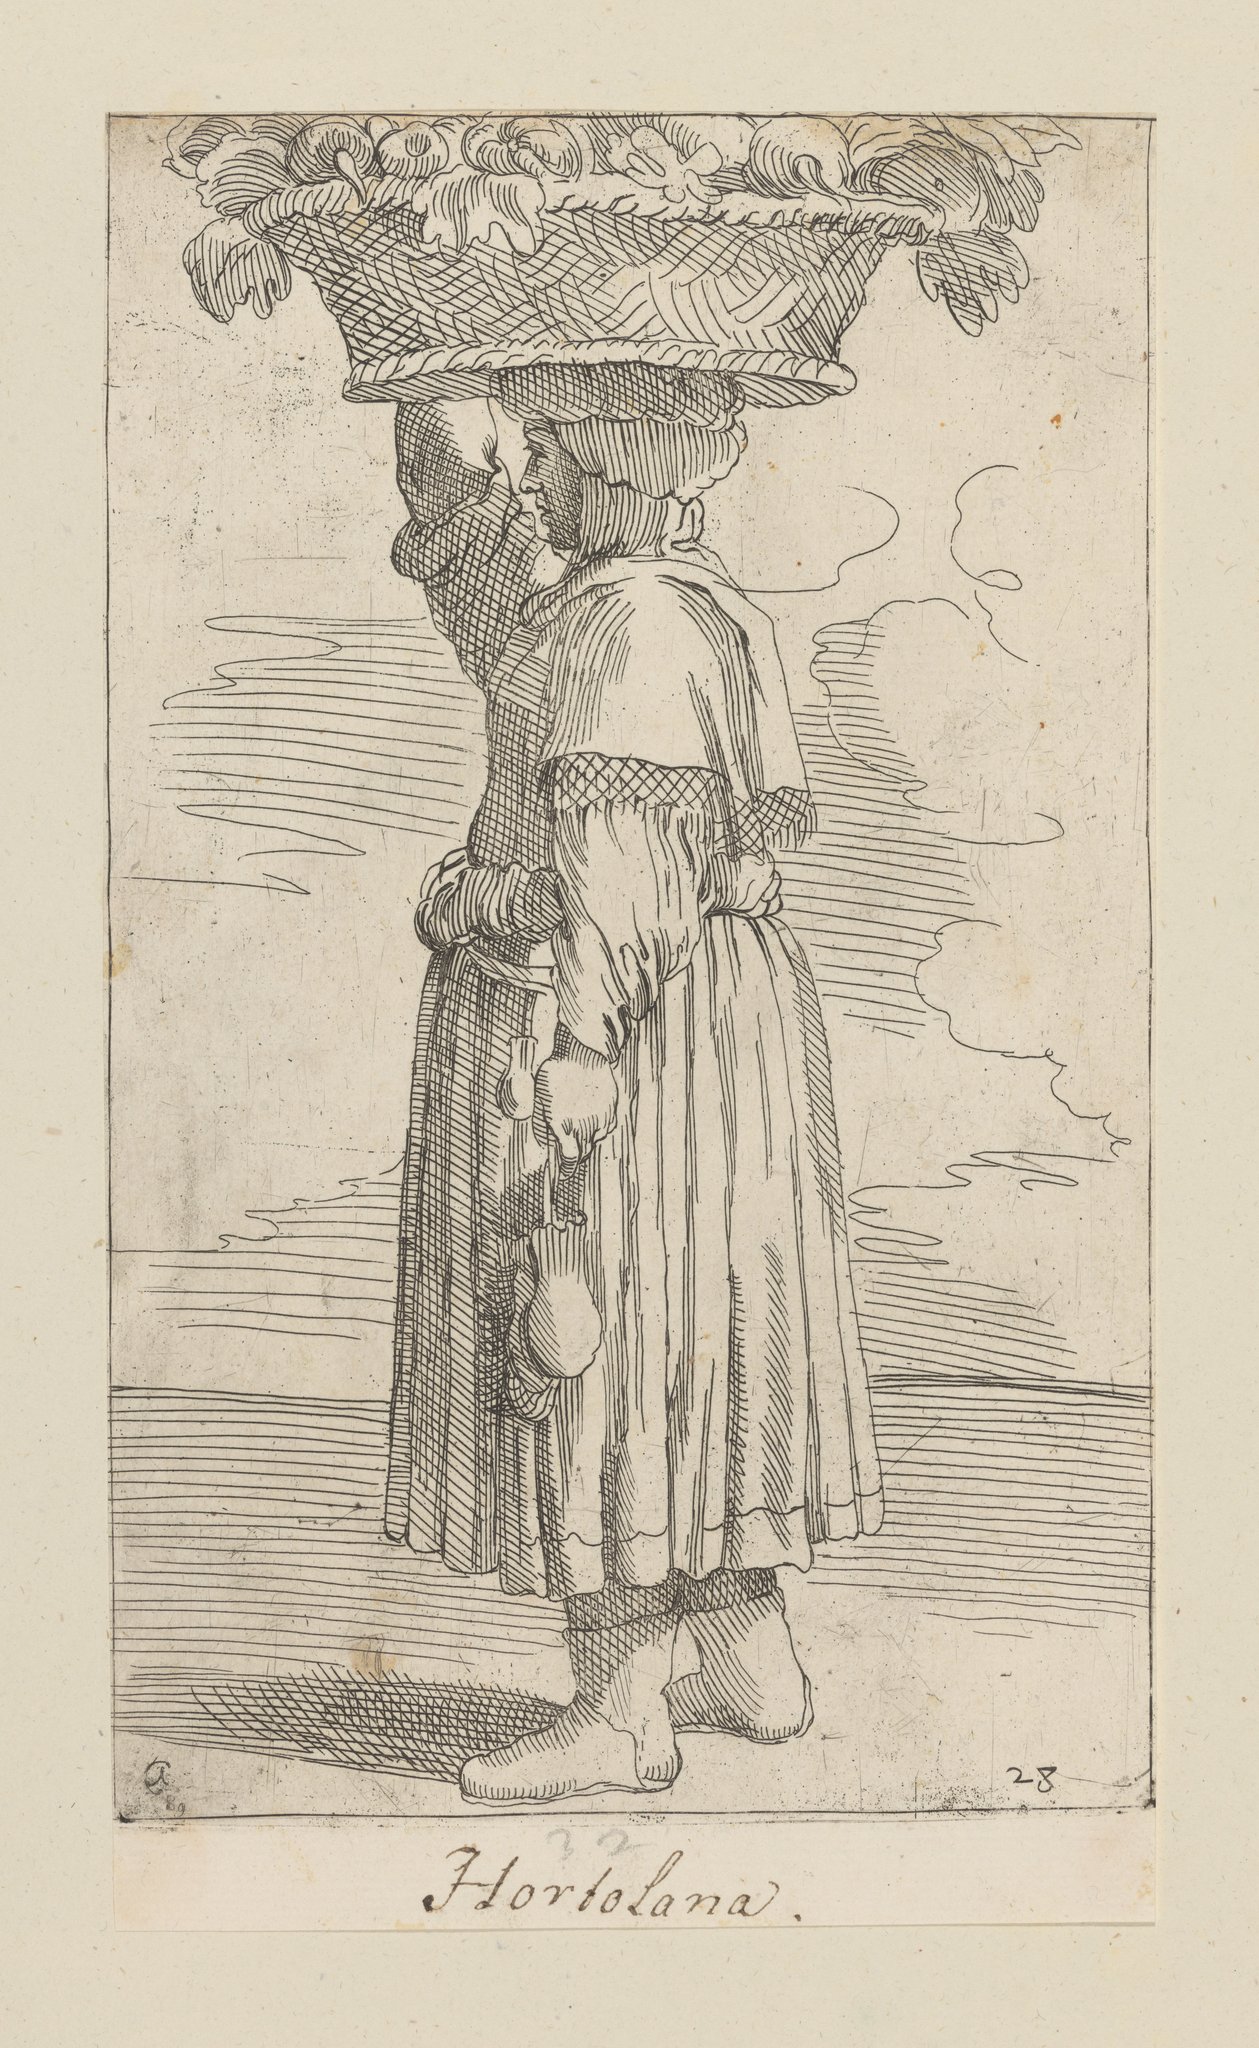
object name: print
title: Plate 28: Gardener (garden produce)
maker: simon guillain ii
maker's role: artist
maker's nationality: french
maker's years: 1618-1718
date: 1646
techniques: etching